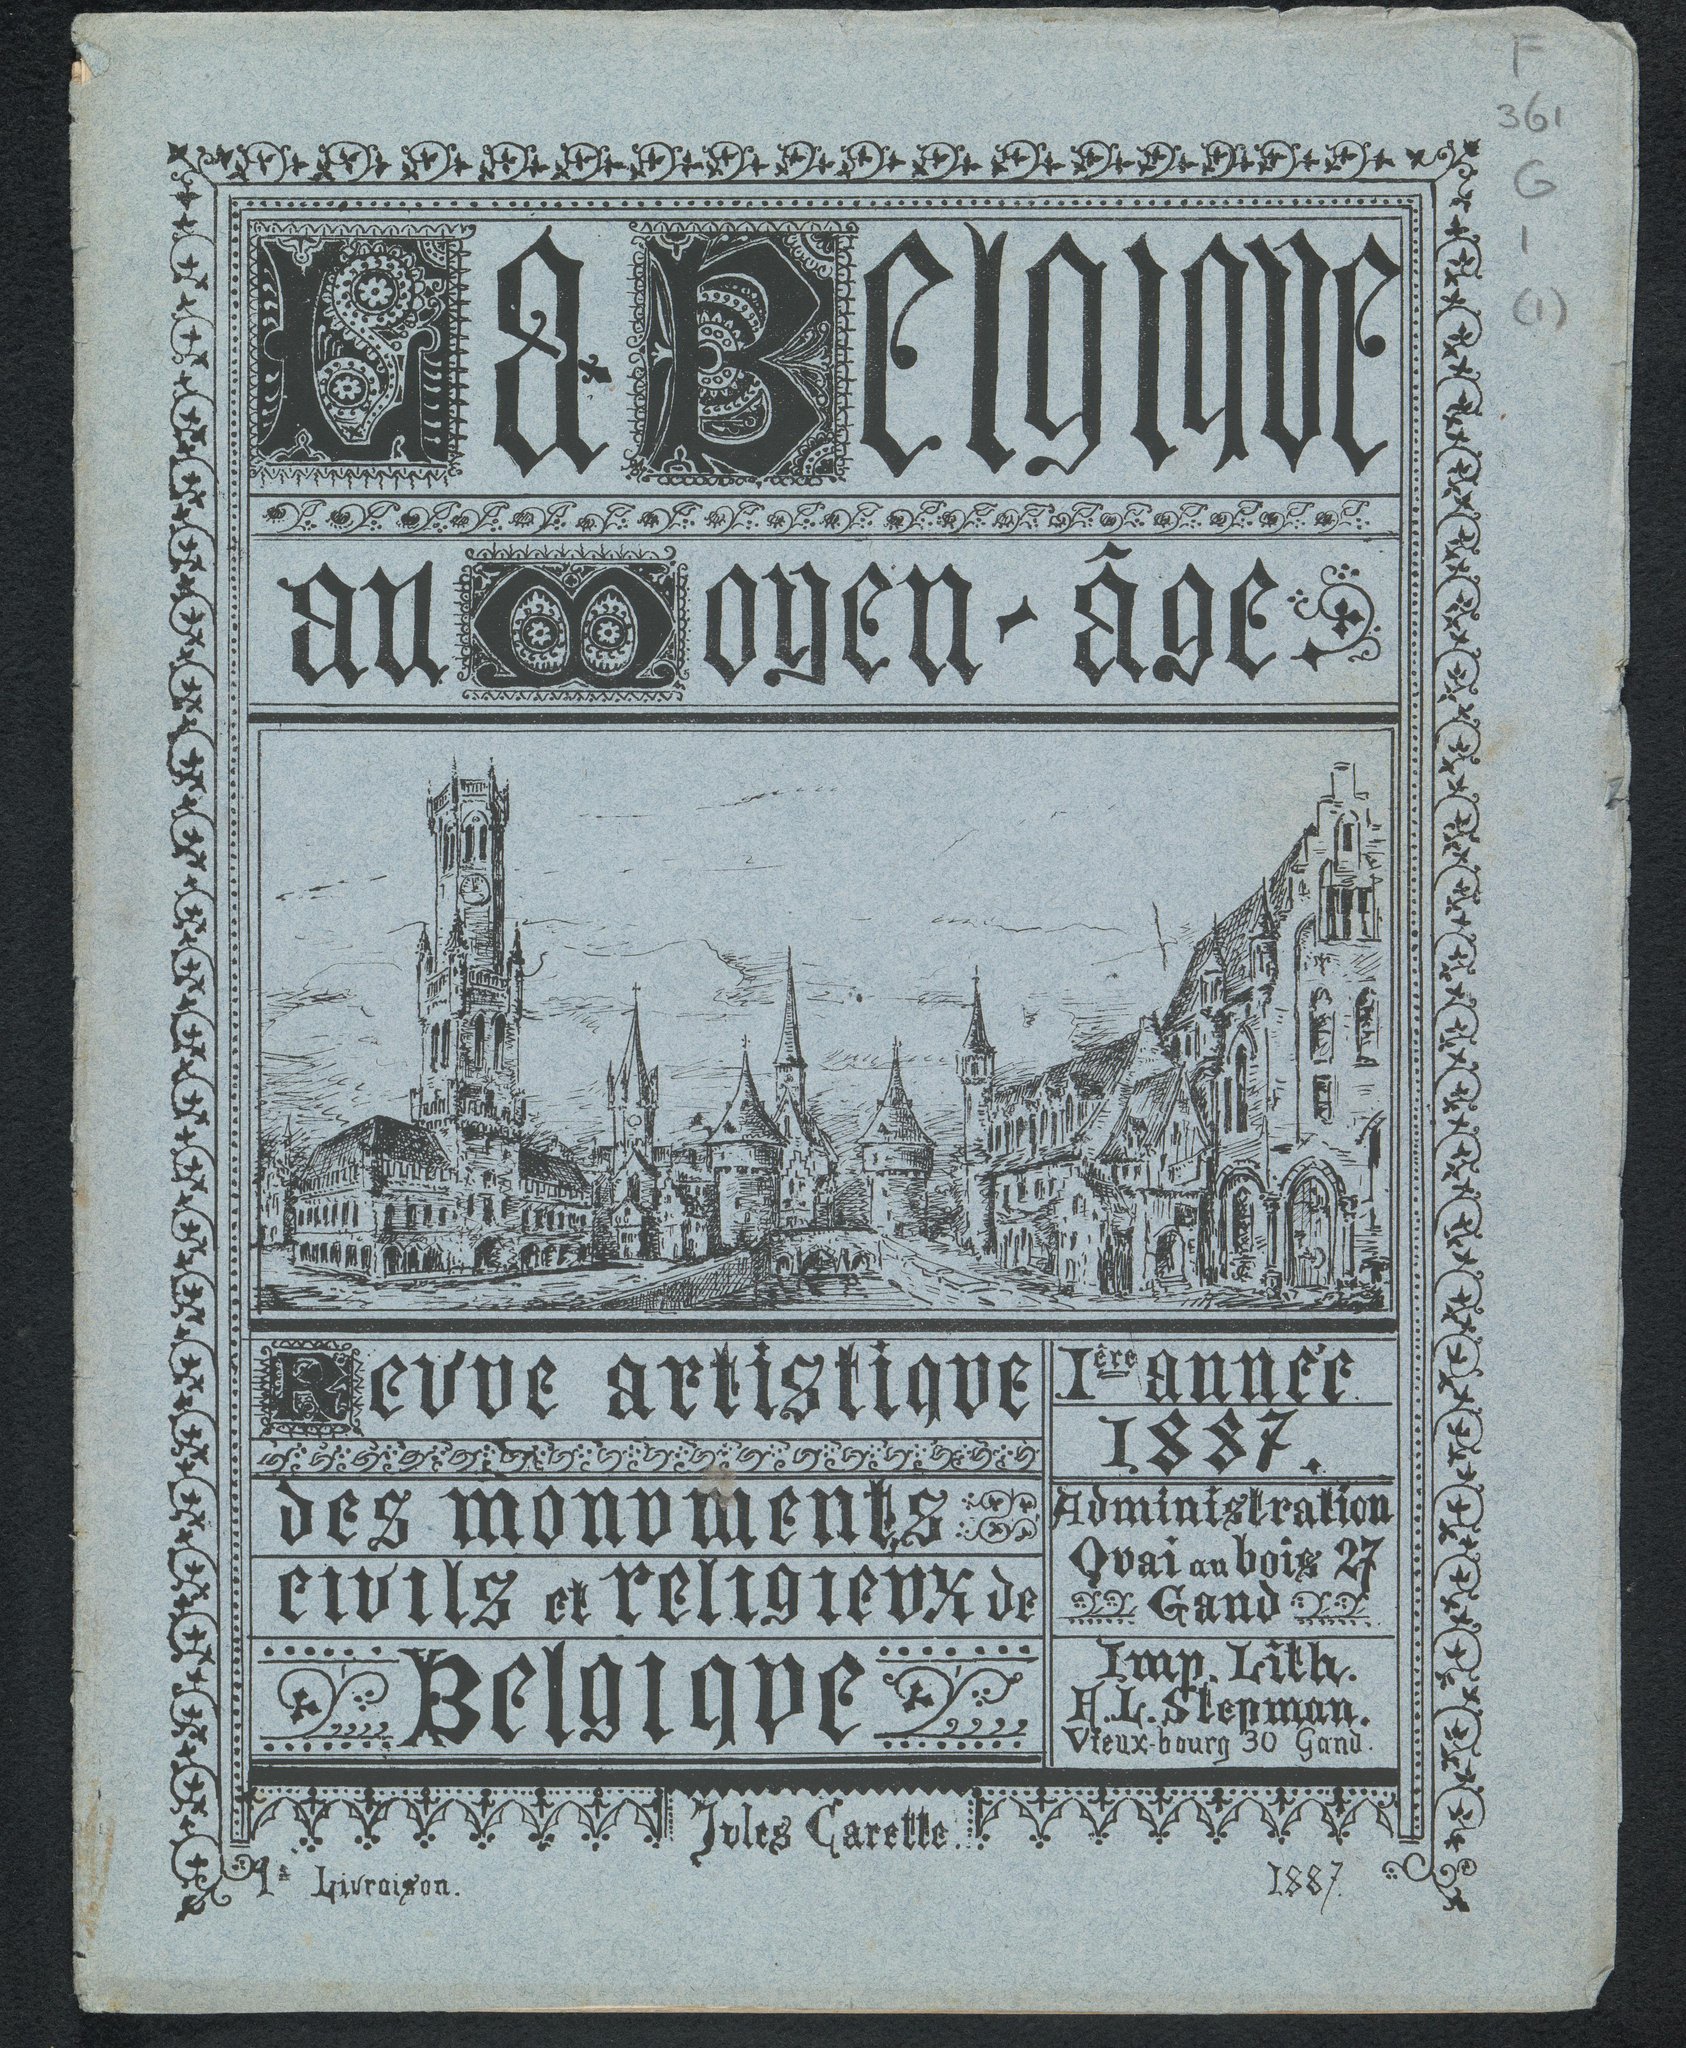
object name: book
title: La Belgique au moyen-âge : revue artistique des monuments civils et religieux de Belgique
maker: h.l. stepman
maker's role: printer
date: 1887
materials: cardboard, paper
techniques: cyanotype, printing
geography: ghent